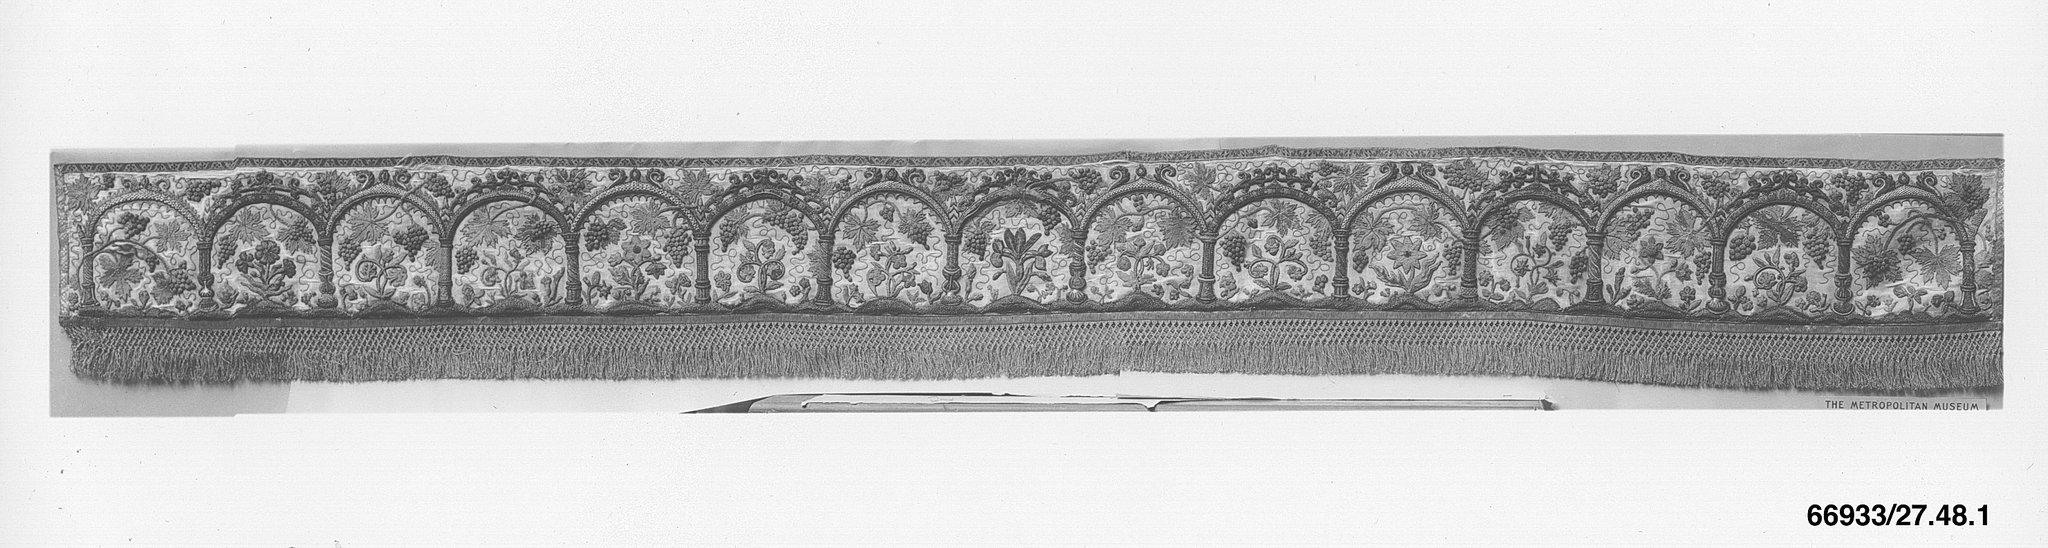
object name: valance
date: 1601-1633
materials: metal thread, silk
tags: grapes